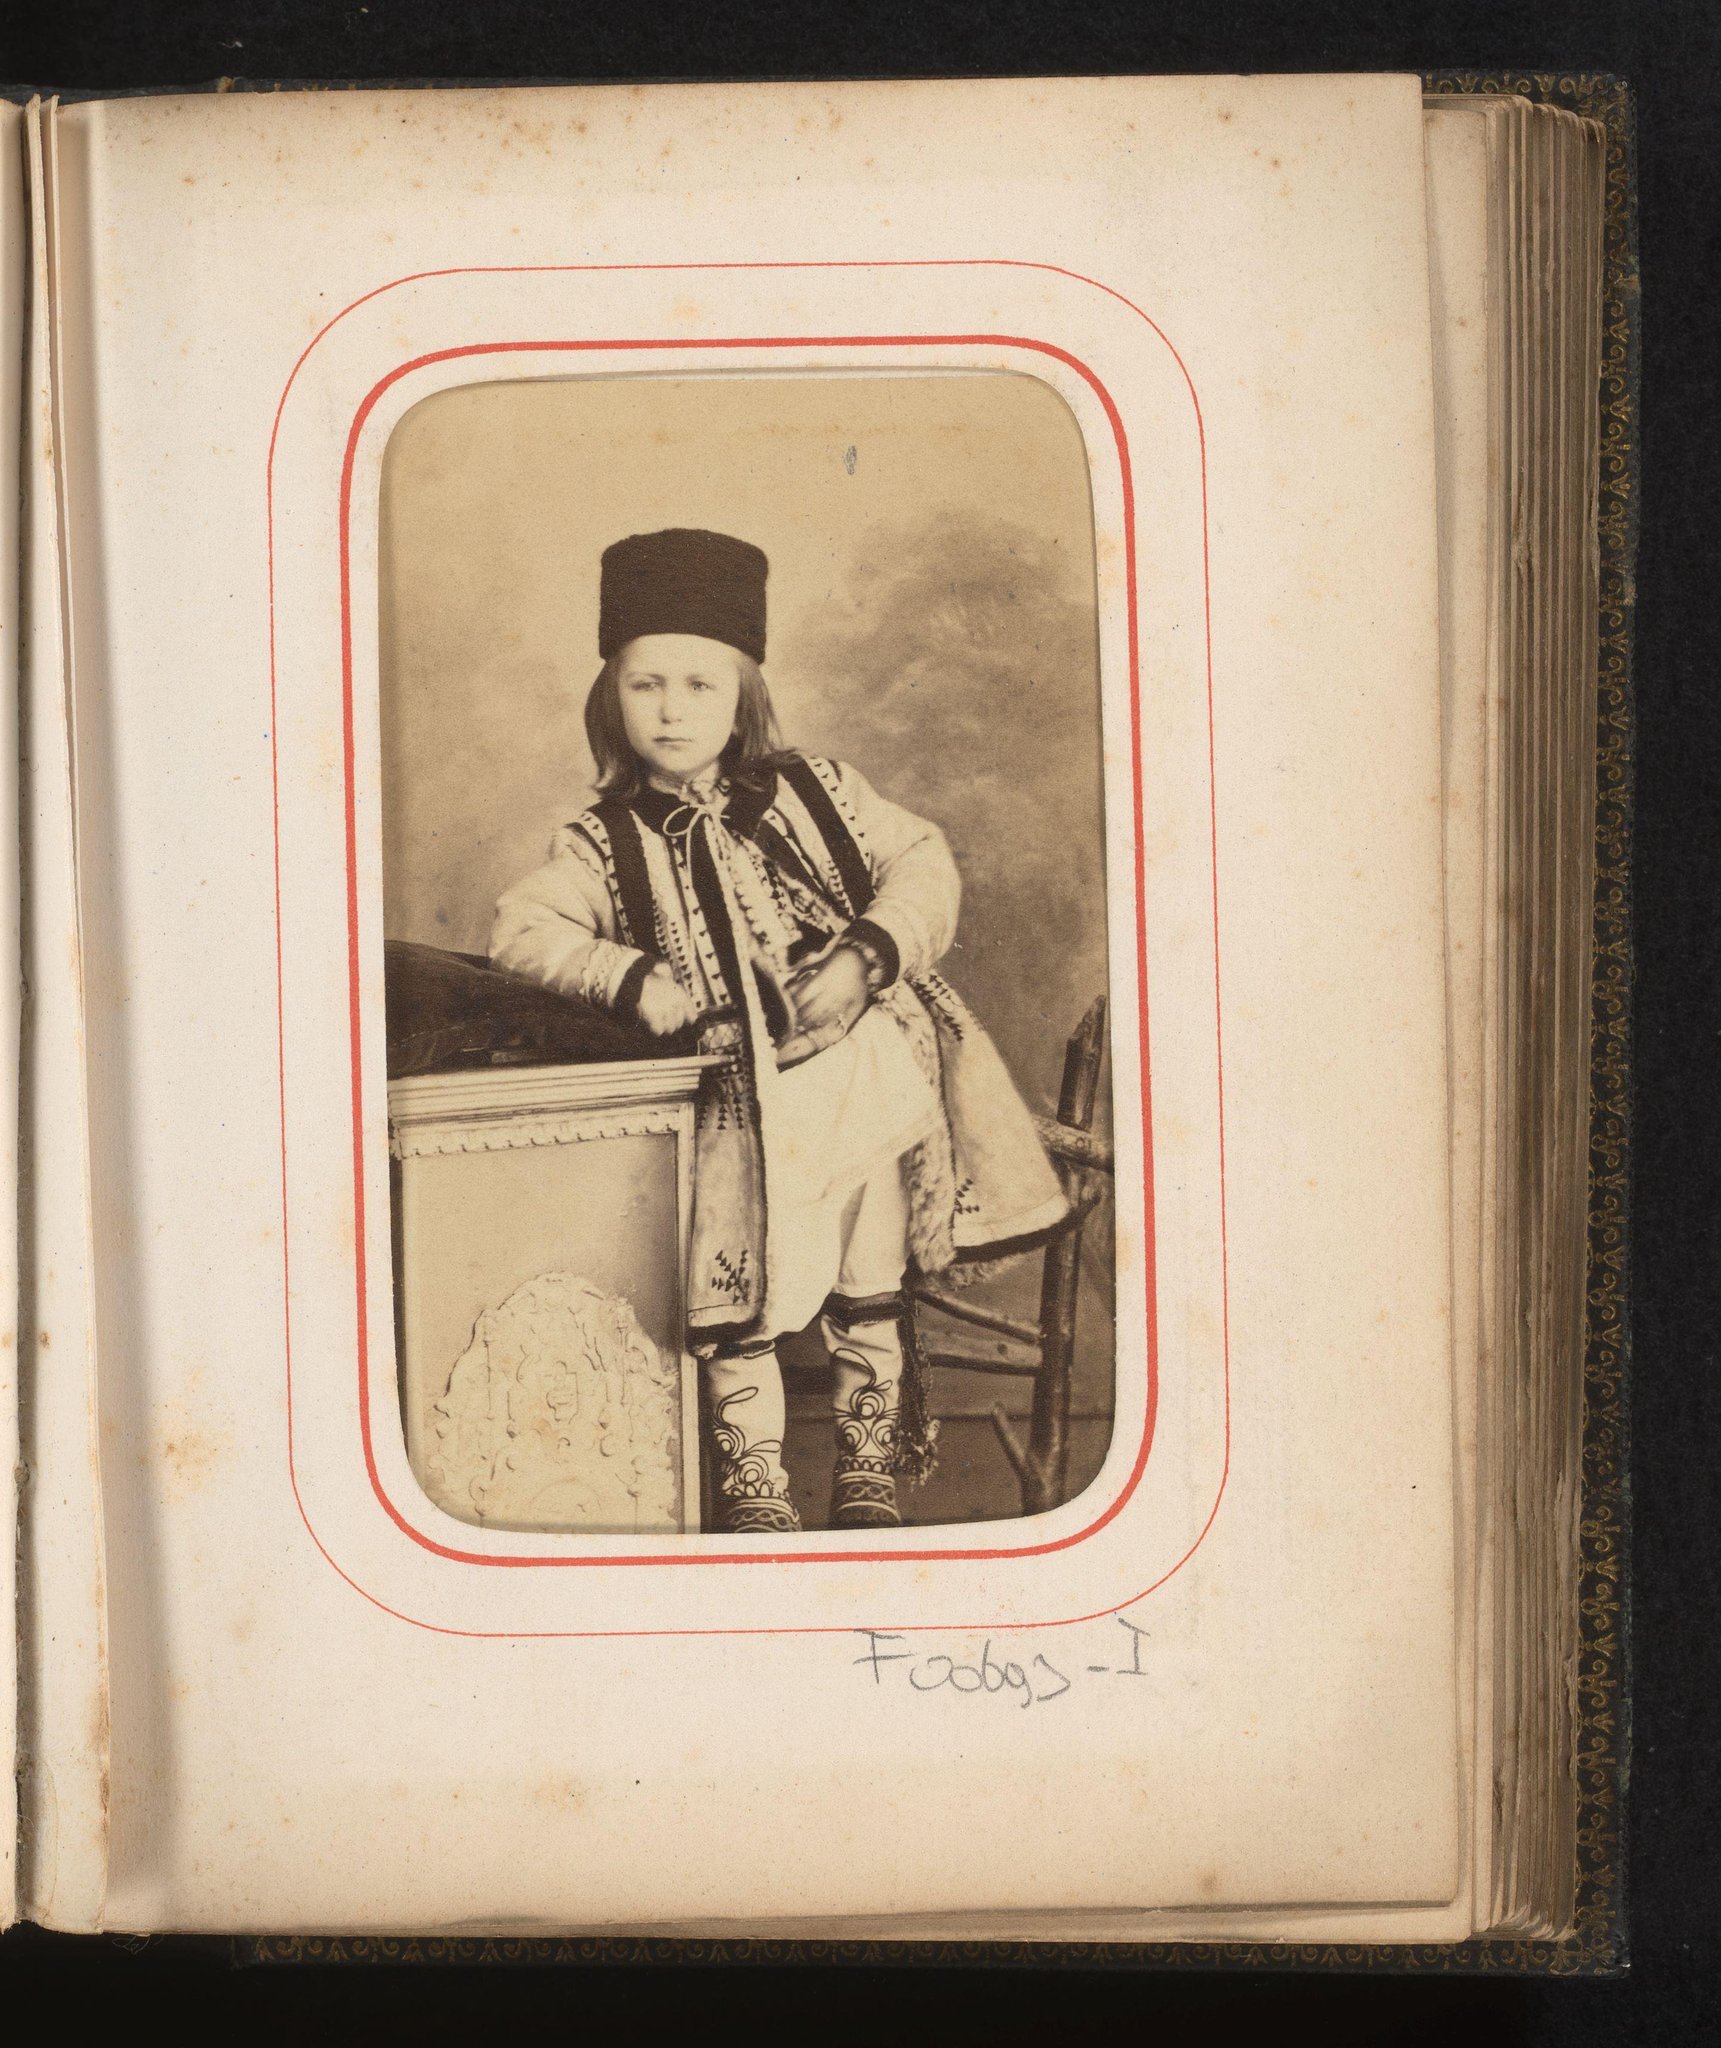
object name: photograph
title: Portret van een jongen in Roemeense klederdracht, staand op een stoel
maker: carol popp de szathmari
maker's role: fotograaf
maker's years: 1812-1887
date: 1870-1890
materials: cardboard, photographic support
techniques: albumen print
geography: bucharest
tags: boy (child between toddler and youth), historical persons, folk costume, regional costume, chair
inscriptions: inscription: ‘CHARLES SZATHMARI/ Peintre et Photographe de la Cour/ DE SALE PRINCE REGNANT/ des Principautées unies Roumaines./ (...)/ BUCAREST.’, annotation: ‘campolungo’